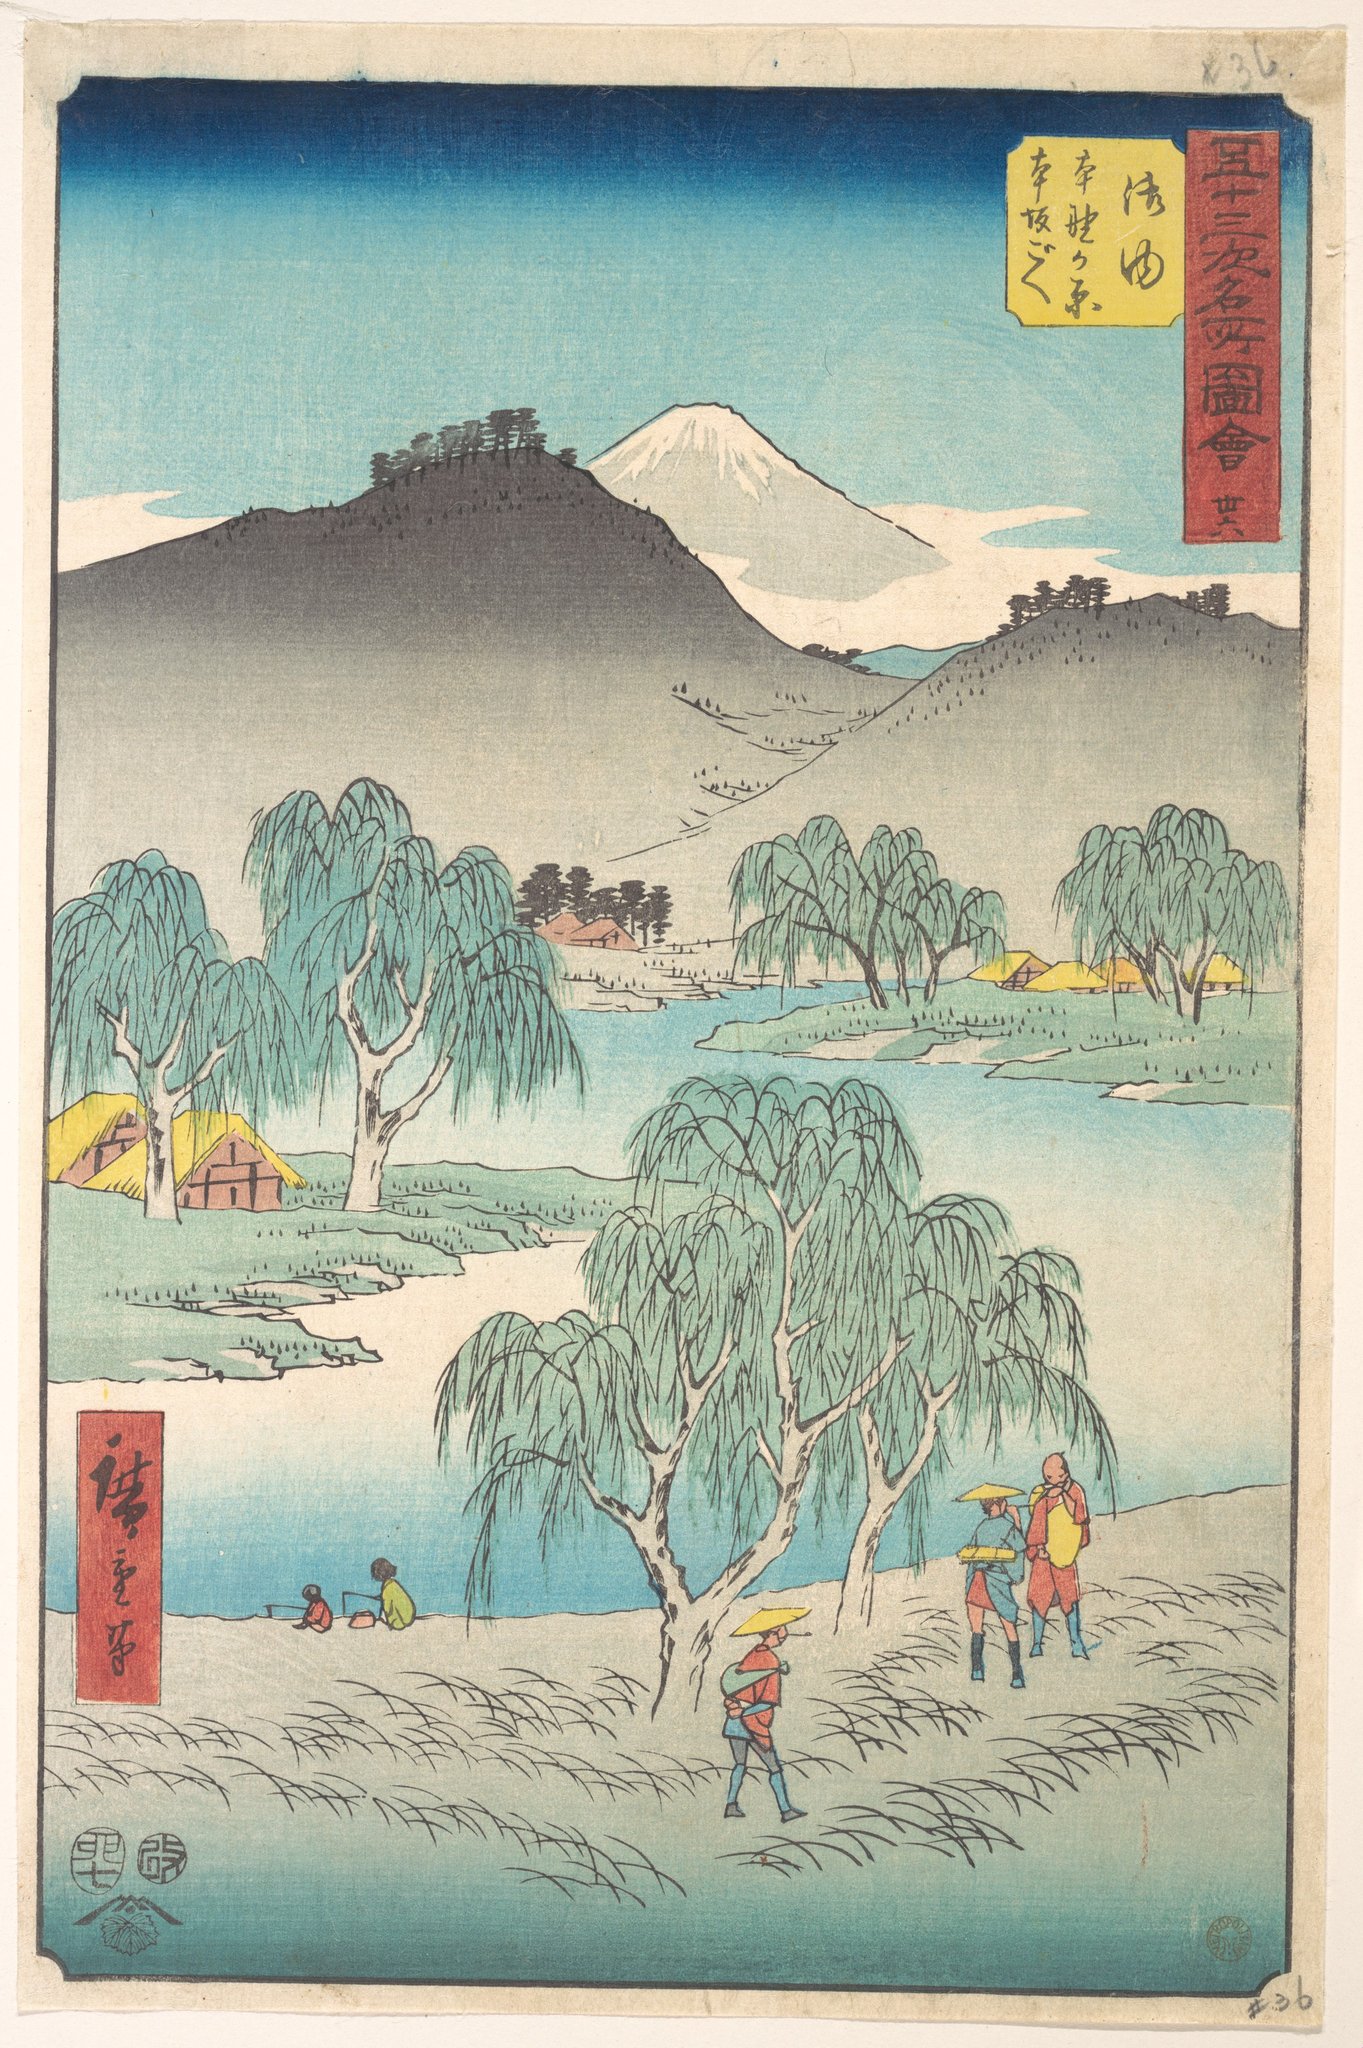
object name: print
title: Goyu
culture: japanese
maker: utagawa hiroshige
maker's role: artist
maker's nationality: japanese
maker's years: 1797-1858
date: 1855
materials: ink, paper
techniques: woodblock print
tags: men,rivers,mountains,landscapes,trees